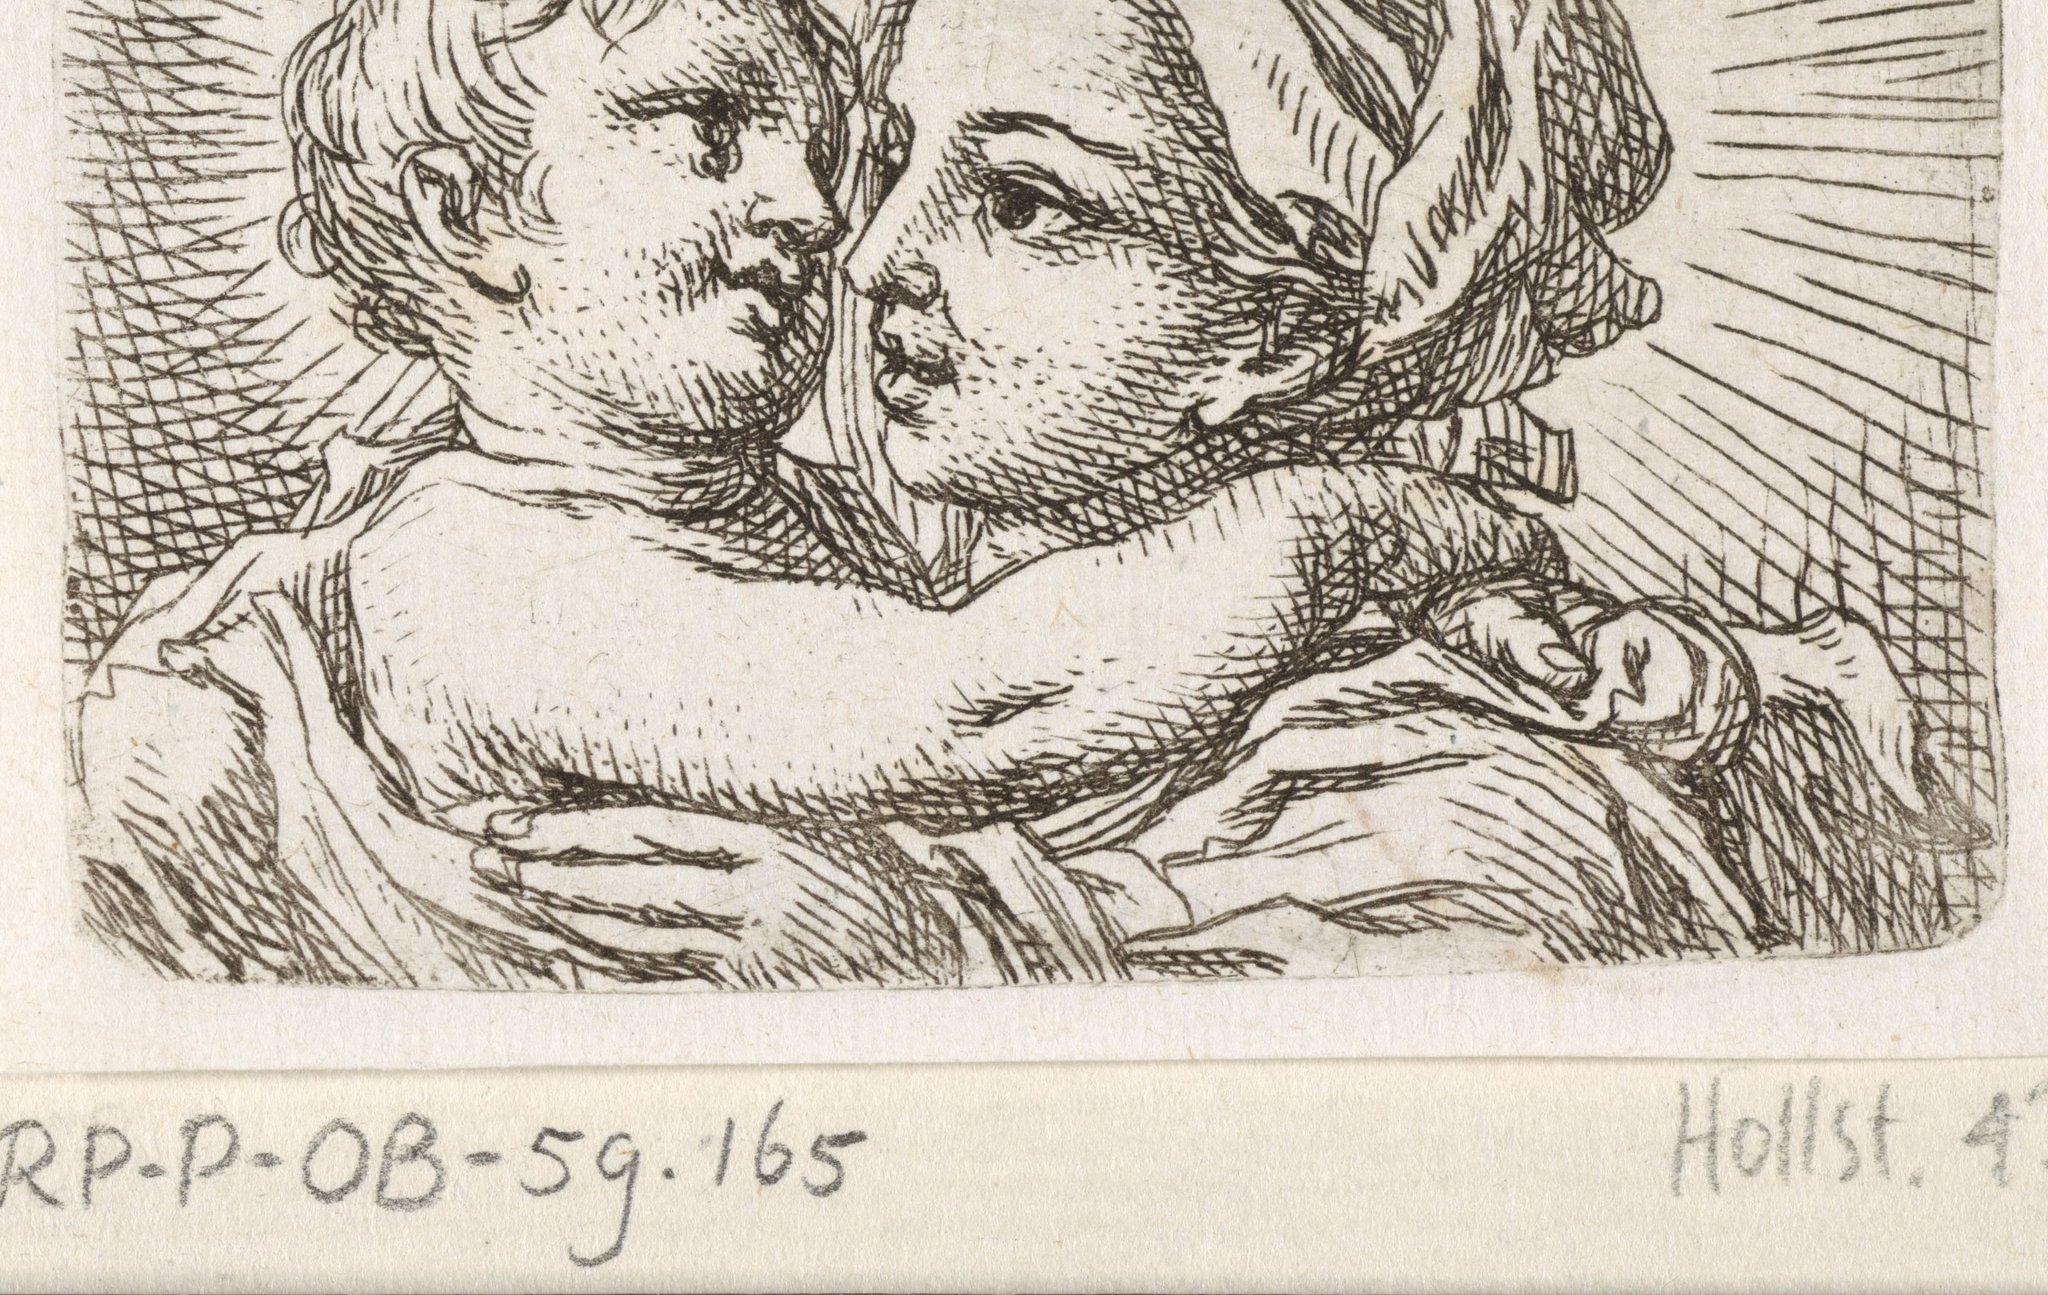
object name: print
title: Madonna met kind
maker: cornelis schut (i)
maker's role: draughtsman, print maker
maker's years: 1597-1655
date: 1618-1655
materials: paper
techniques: etching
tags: madonna: i.e. mary with the christ-child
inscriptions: collector's mark: Lugt 240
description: Maria houdt het Christuskind op ooghoogte. Hij heeft zijn armen om haar hals geslagen.